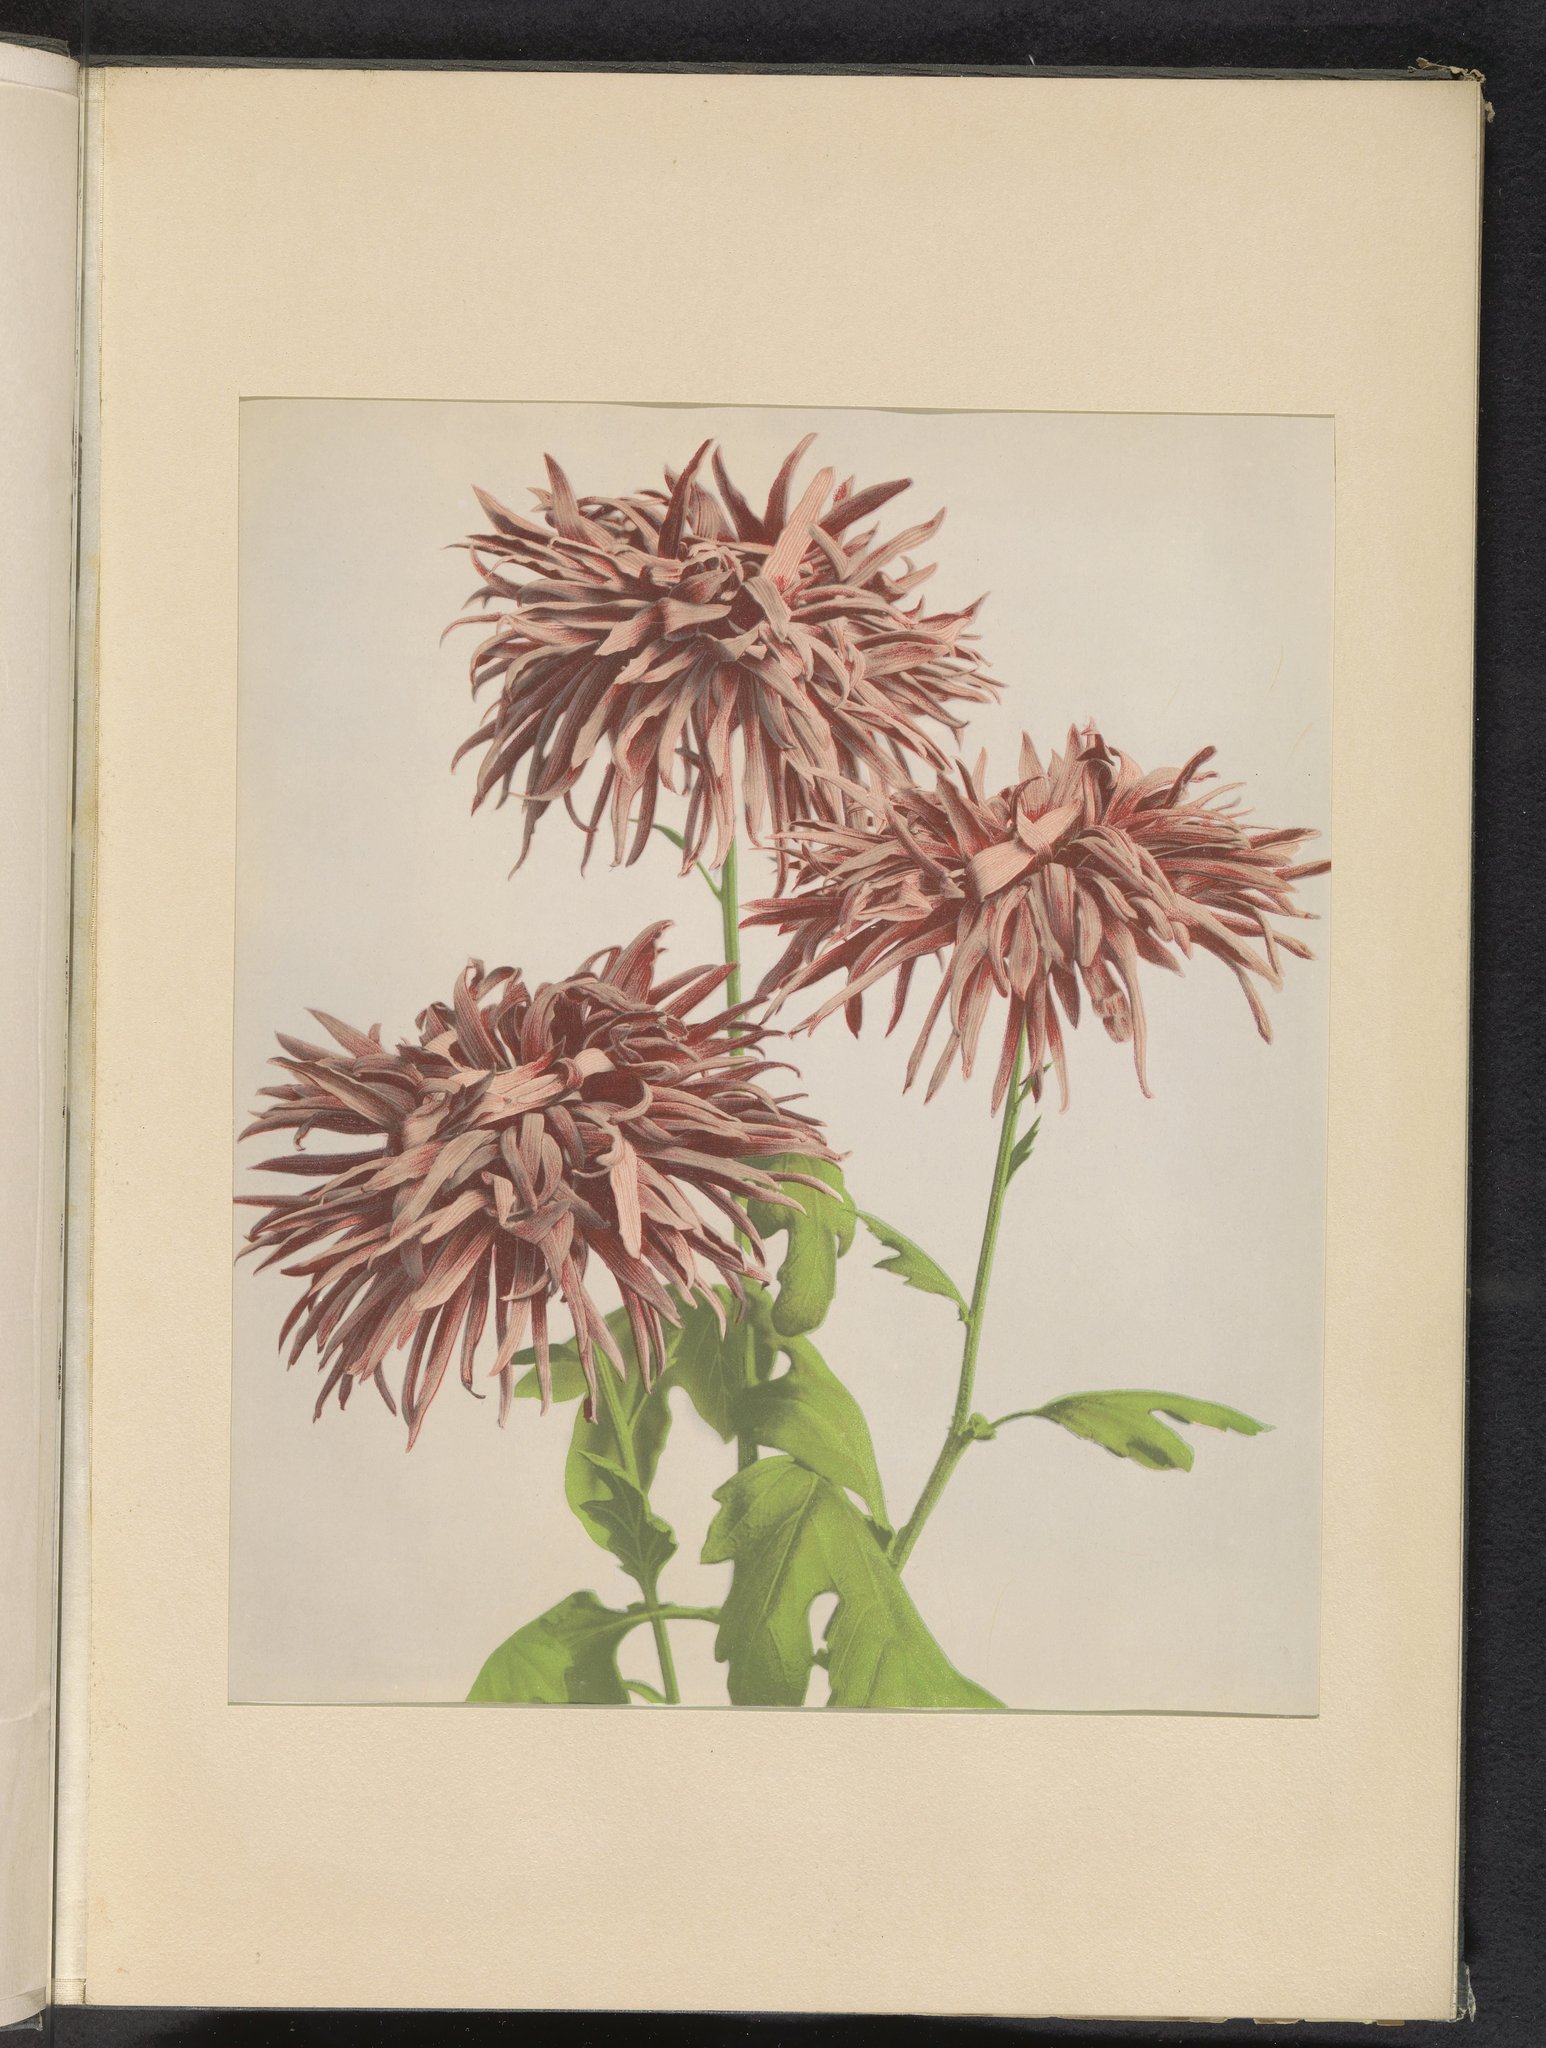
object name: photomechanical print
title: Drie roze chrysanten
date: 1887-1897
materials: paper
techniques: photograph, hand coloring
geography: japan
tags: flowers